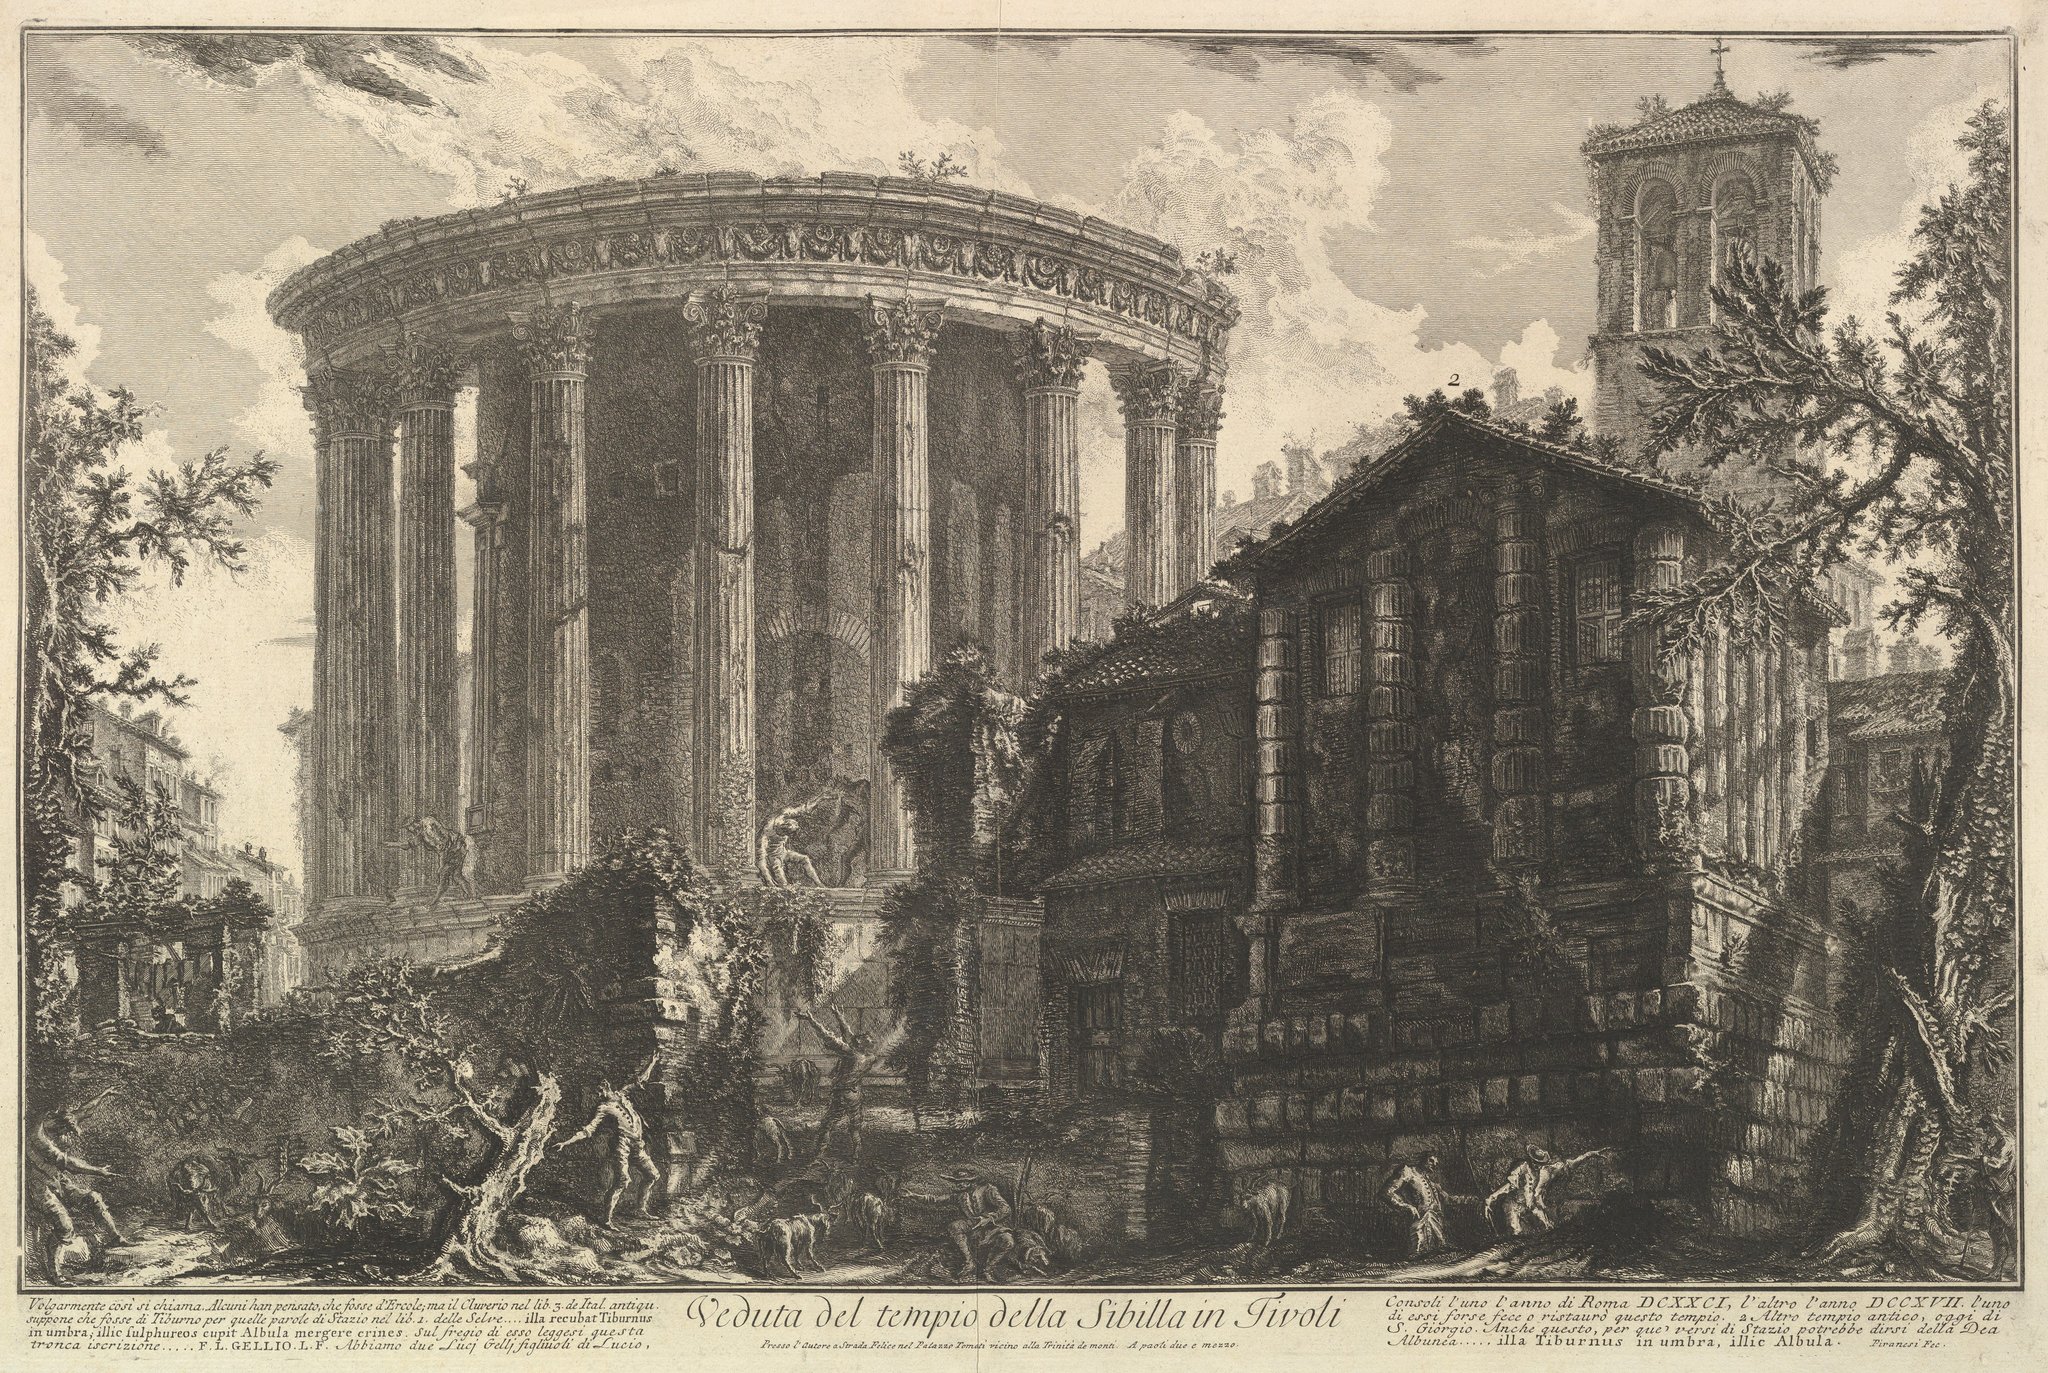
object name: print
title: View of the Temple of the Temple of the Sibyl at Tivoli, from Vedute di Roma (Roman Views)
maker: giovanni battista piranesi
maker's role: artist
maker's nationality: italian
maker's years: 1720-1778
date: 1761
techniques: etching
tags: temples,rome